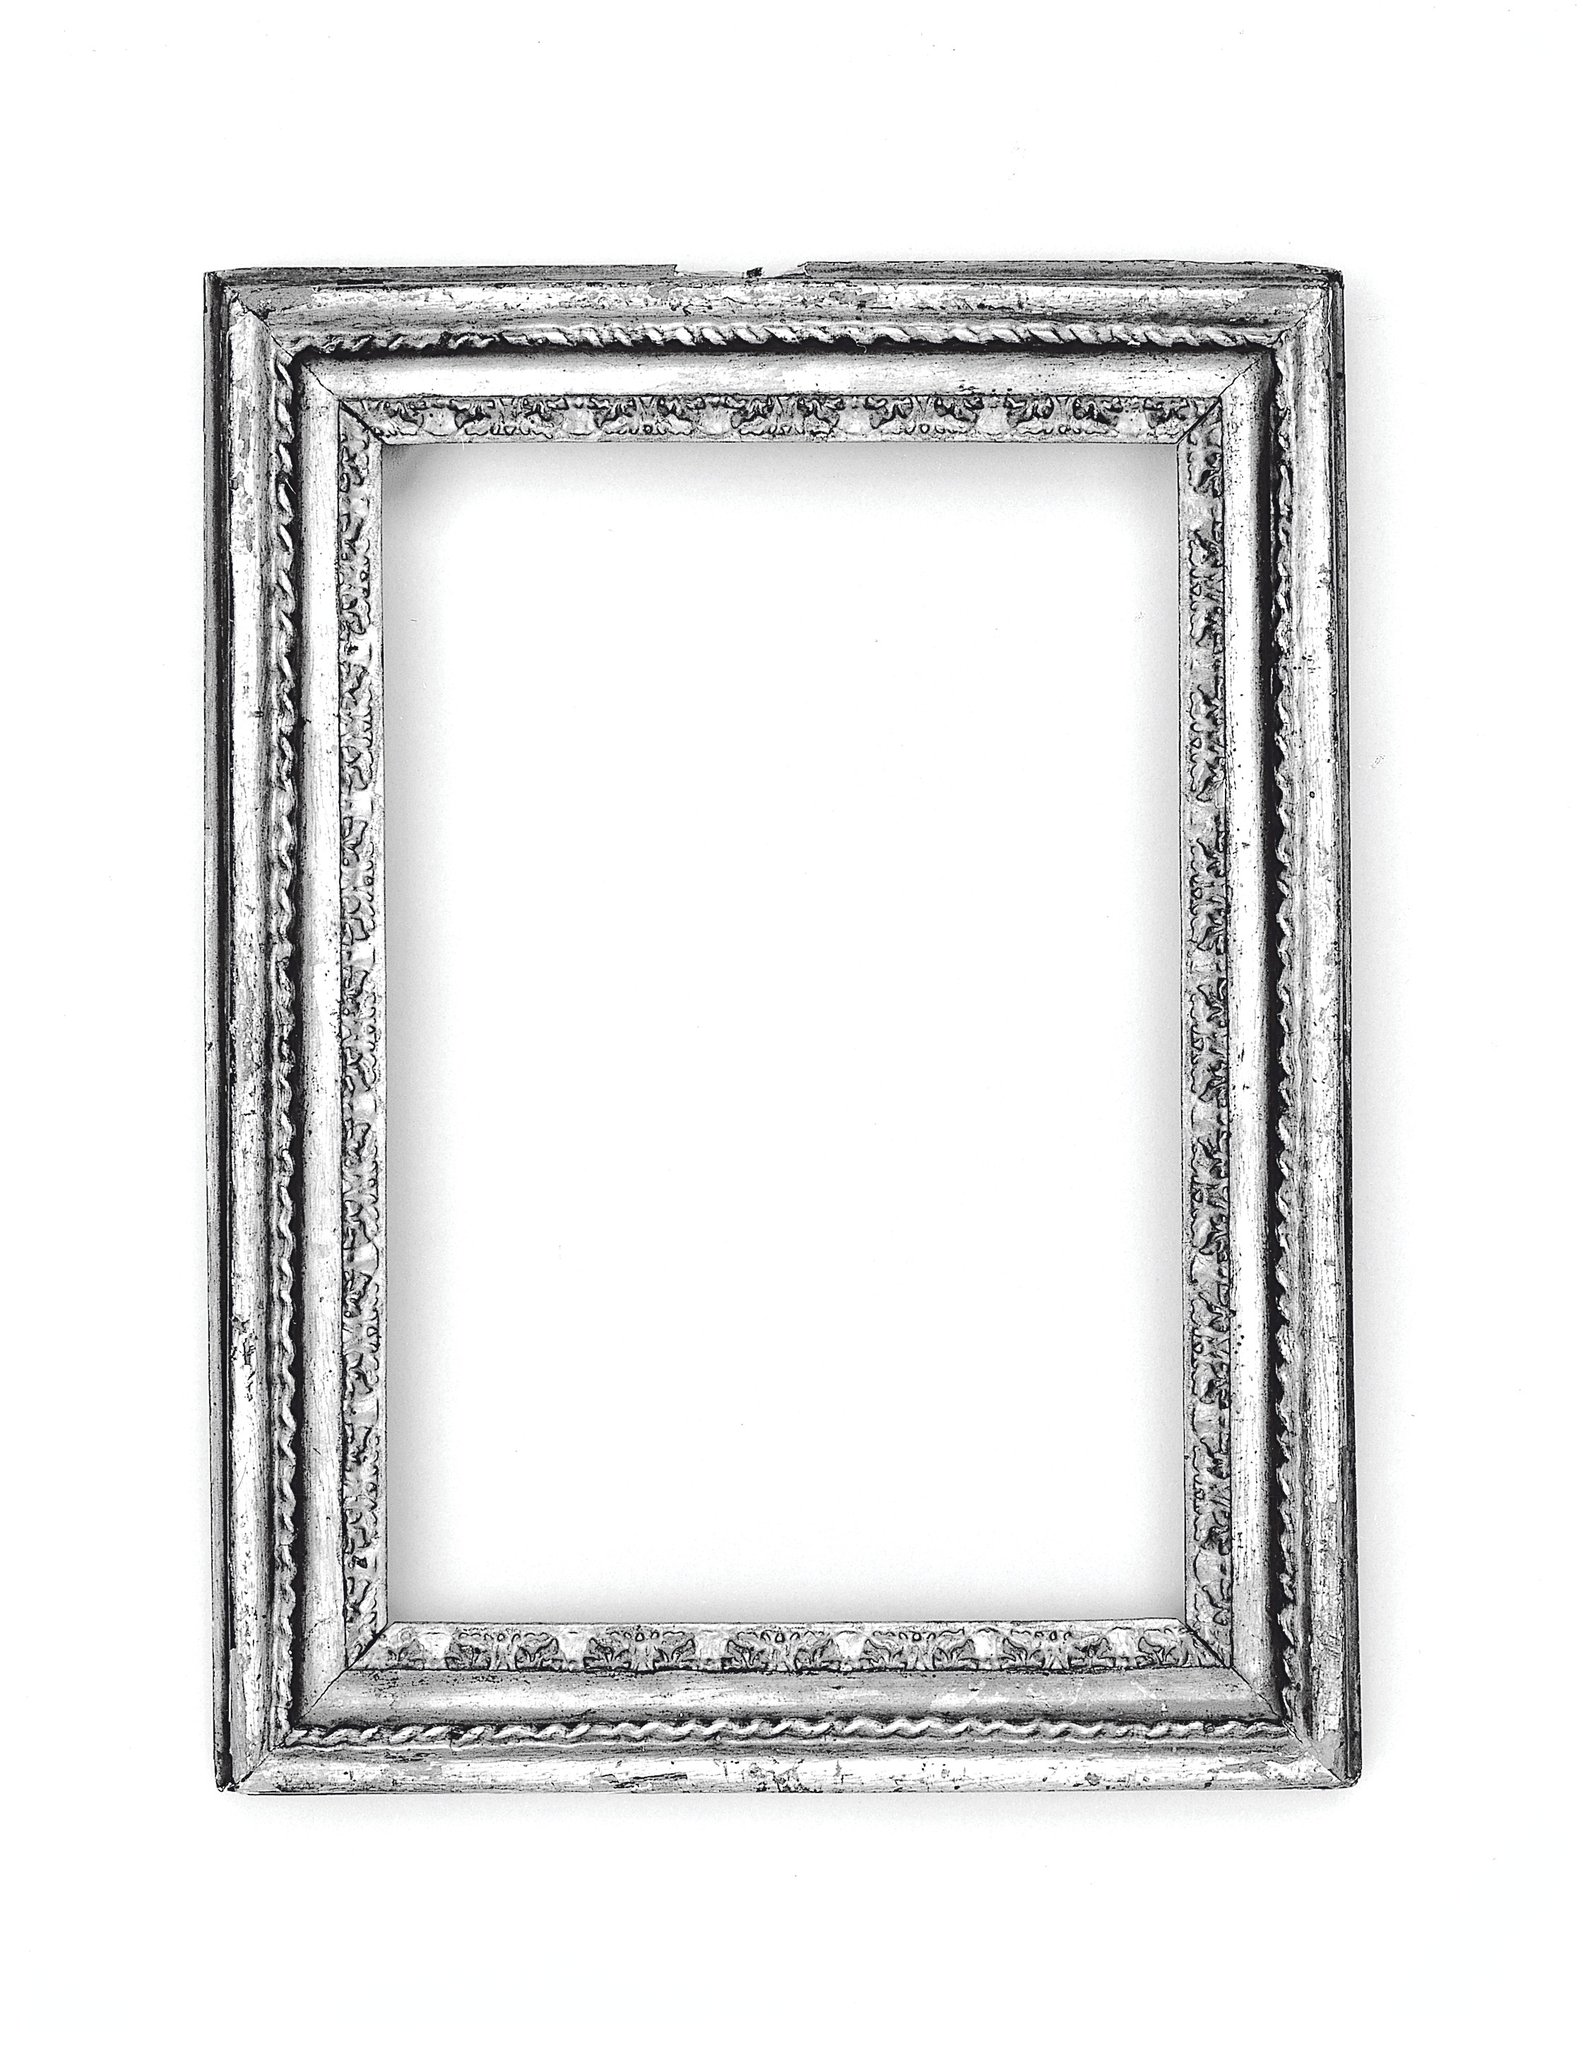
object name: frame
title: Salvator Rosa frame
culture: italian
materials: wood